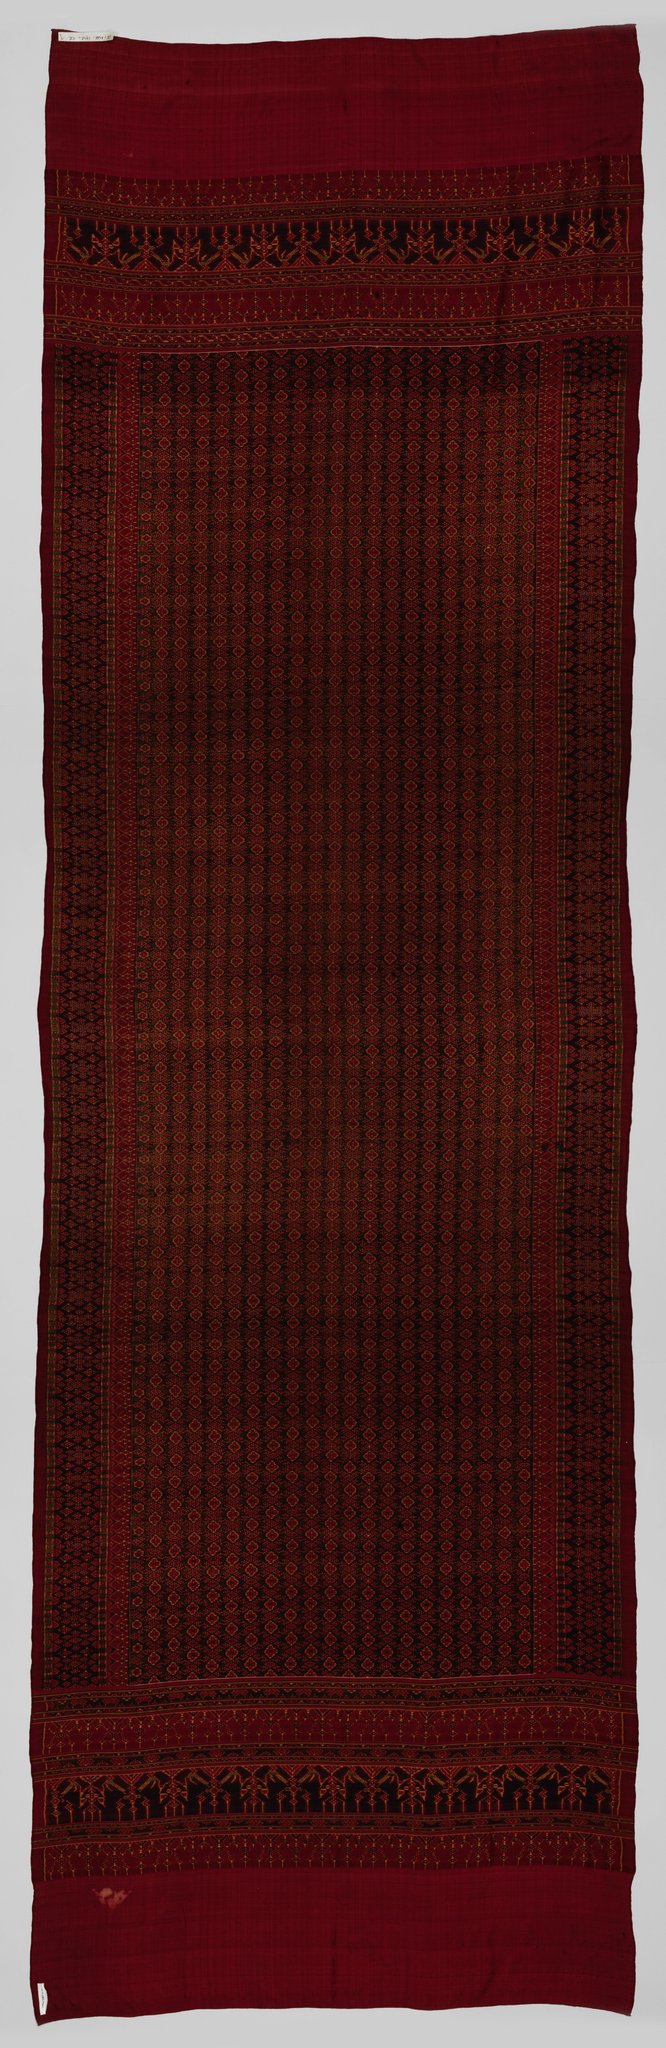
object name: heupdoek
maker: Anonymous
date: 1900-1949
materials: silk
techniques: weave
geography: cambodia